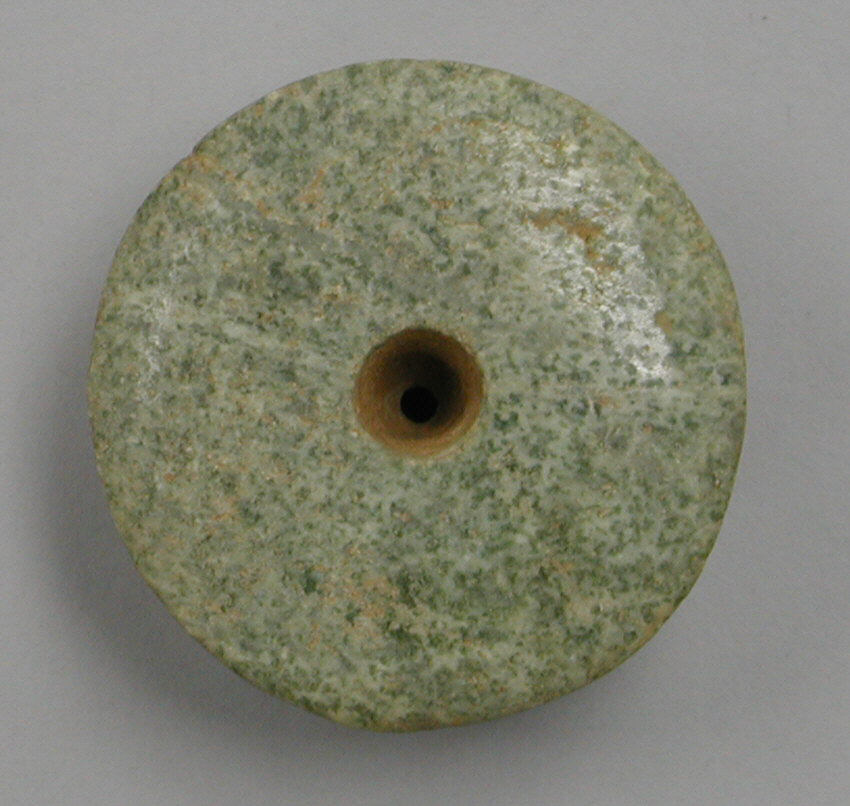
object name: earflare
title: Stone Earflare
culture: mexican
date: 1501-1600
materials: stone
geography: mexico